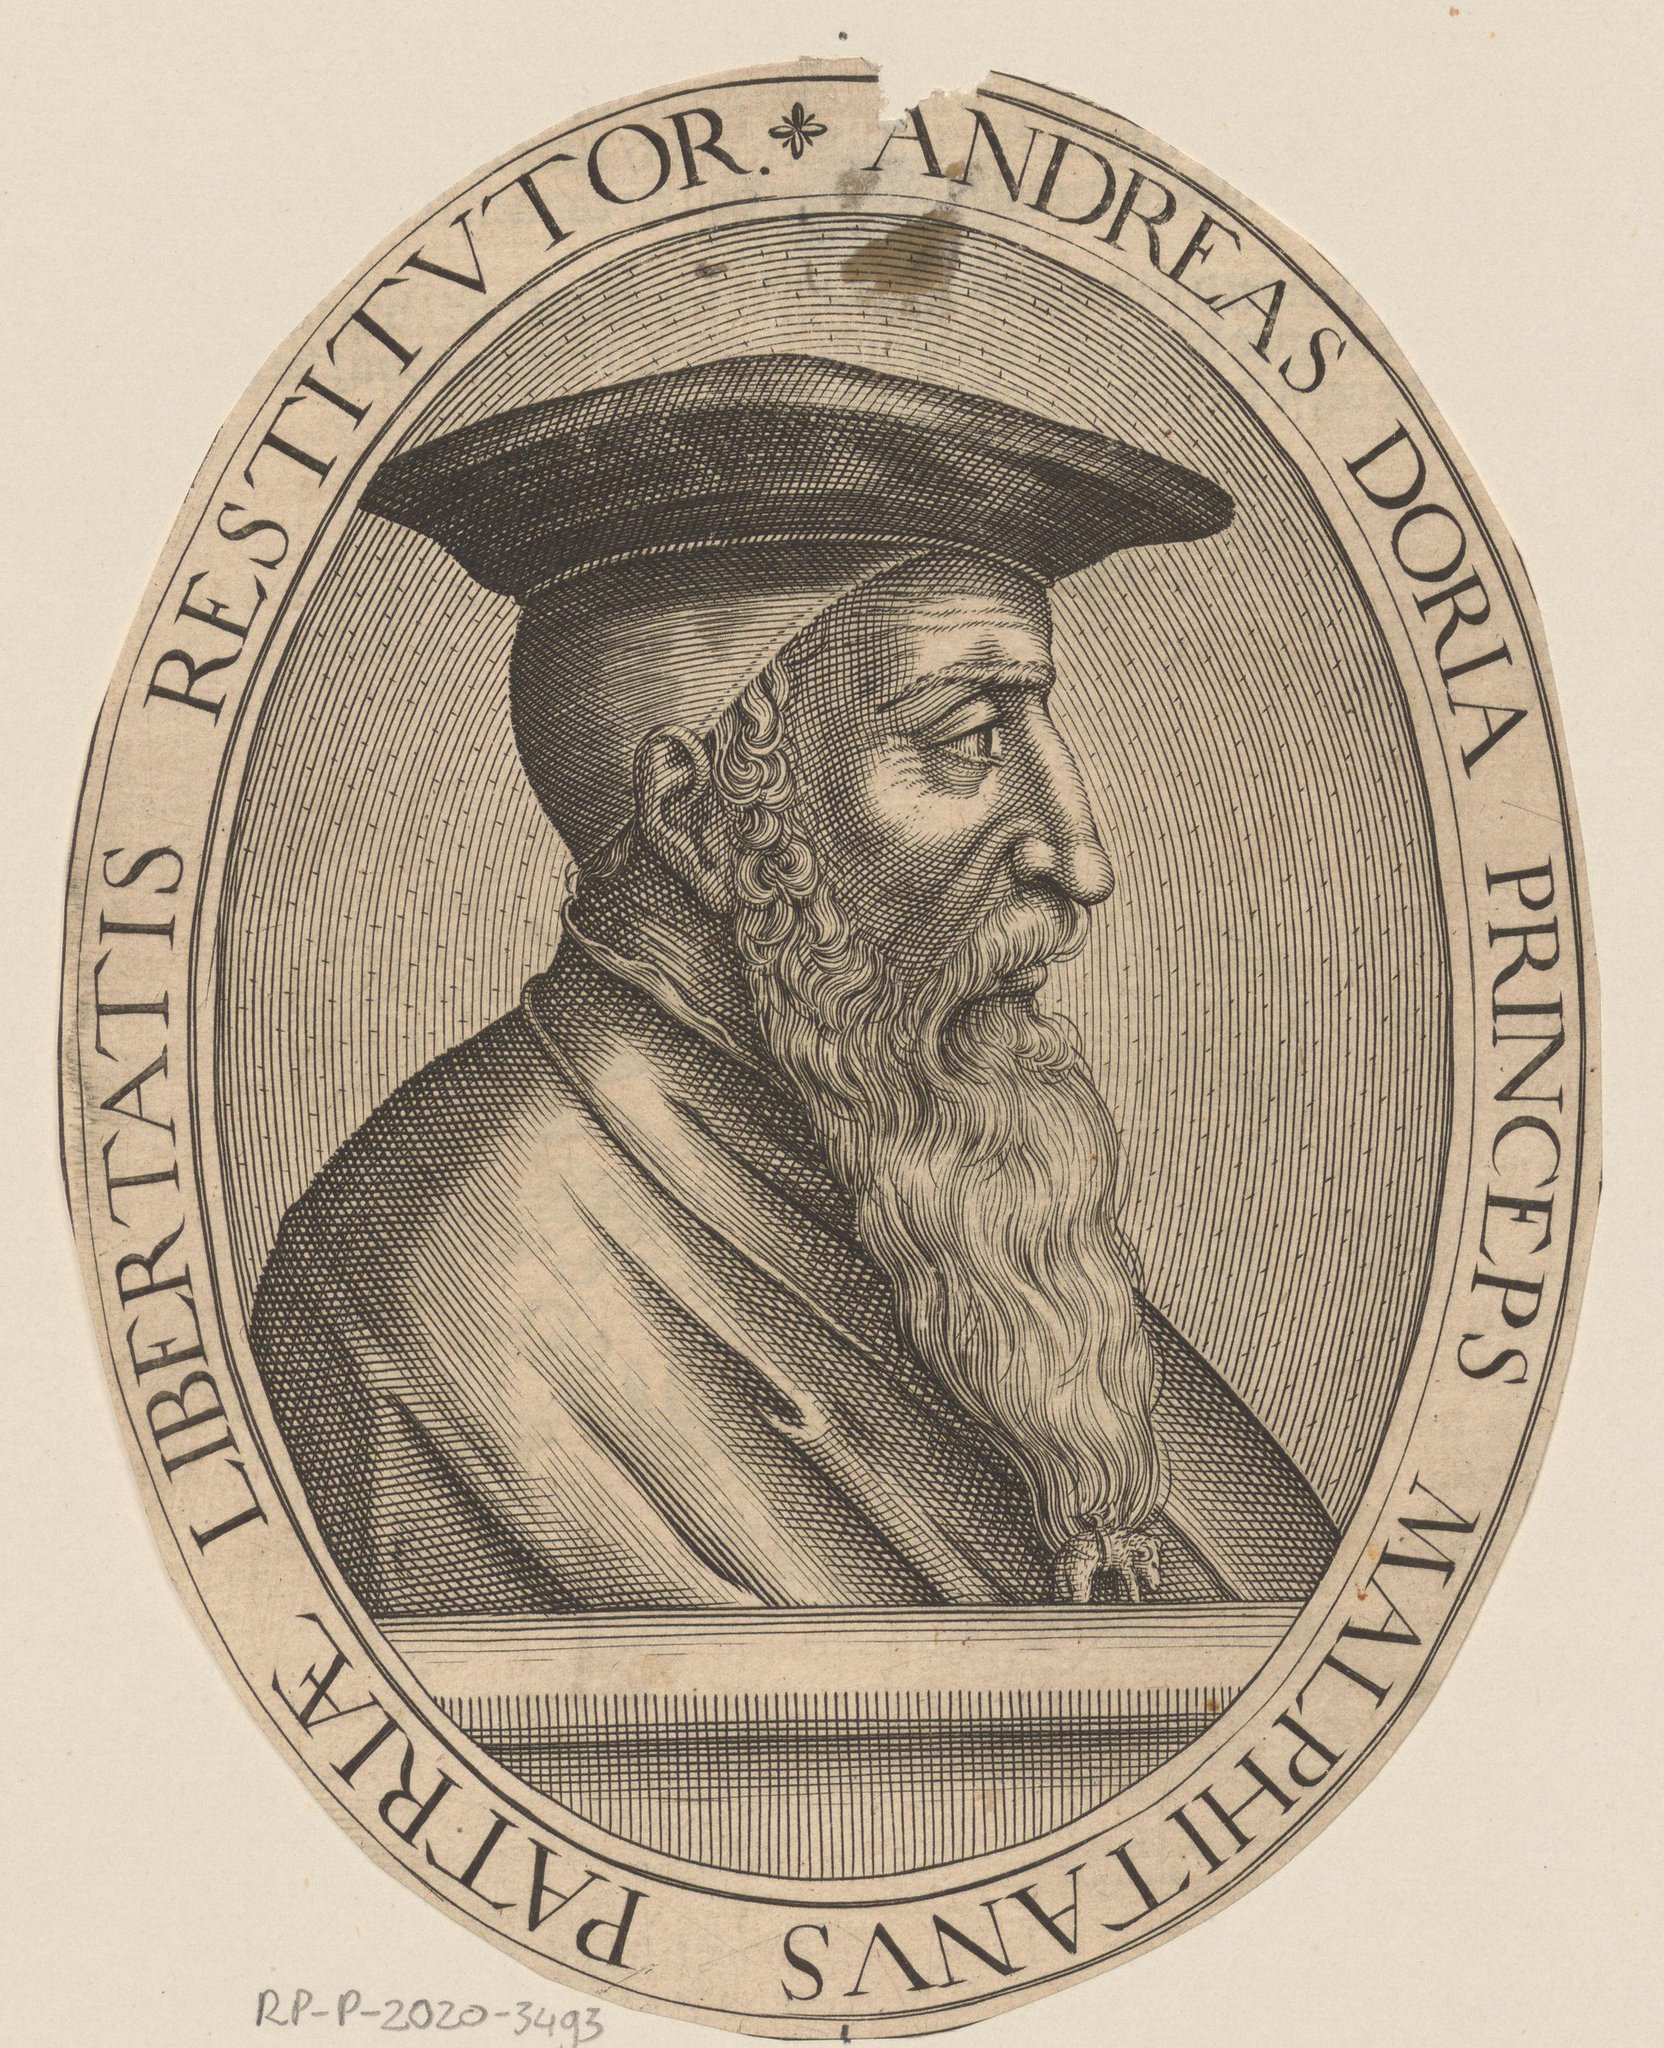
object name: book illustration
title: Portret van Andrea Doria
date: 1617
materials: paper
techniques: engraving, letterpress printing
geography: delft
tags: historical persons, commander-in-chief, admiral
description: Prent uit: Tooneel der beroemder hertogen princen graven ende krygs-helden van christenrijck binnen deze drij laetste eeuwen. Delft: Nicolaes de Clerck, 1617, p. 410.